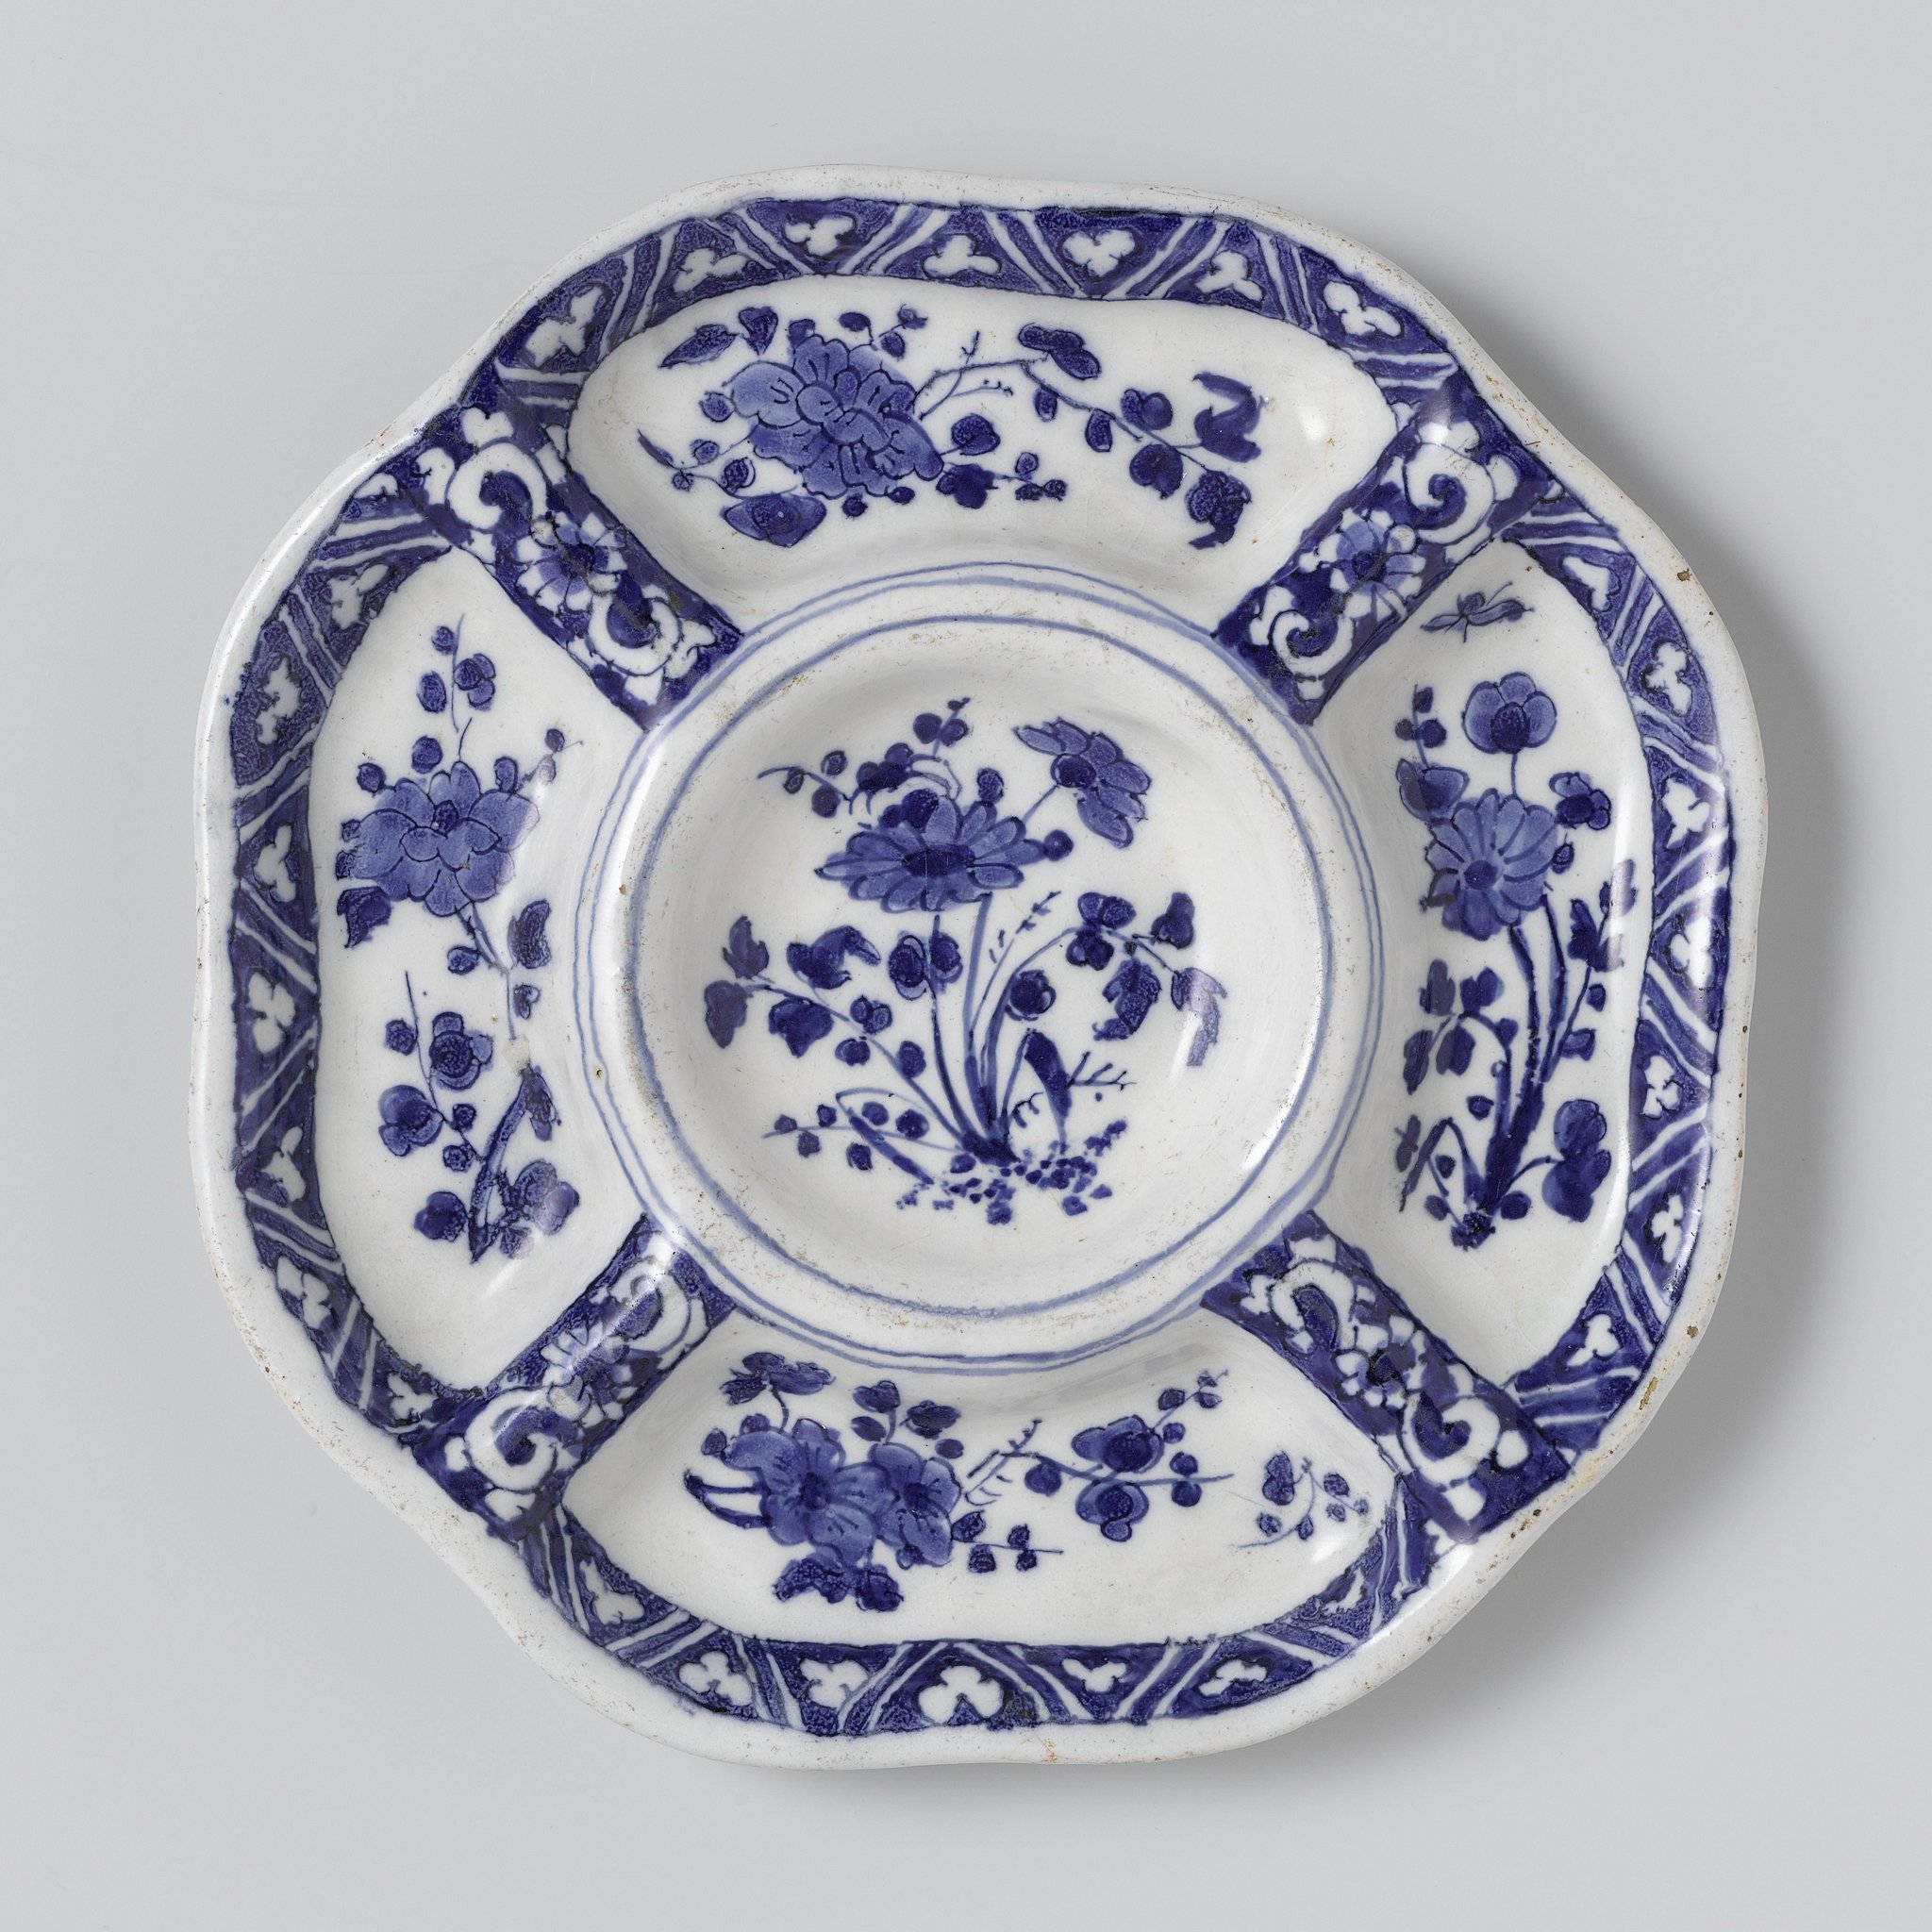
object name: container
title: Octagonal pickle dish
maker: Anonymous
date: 1695-1720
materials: earthenware, glaze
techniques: painted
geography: delft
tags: flowers ~ ornament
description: Achthoekige bak of schaal van in blauw beschilderde faience, met in het midden een ronde bak en daar omheen vier langwerpige bakken. Alle bakken zijn met bloemen en bladeren beschilderd. Zie ook BK-NM-9521.